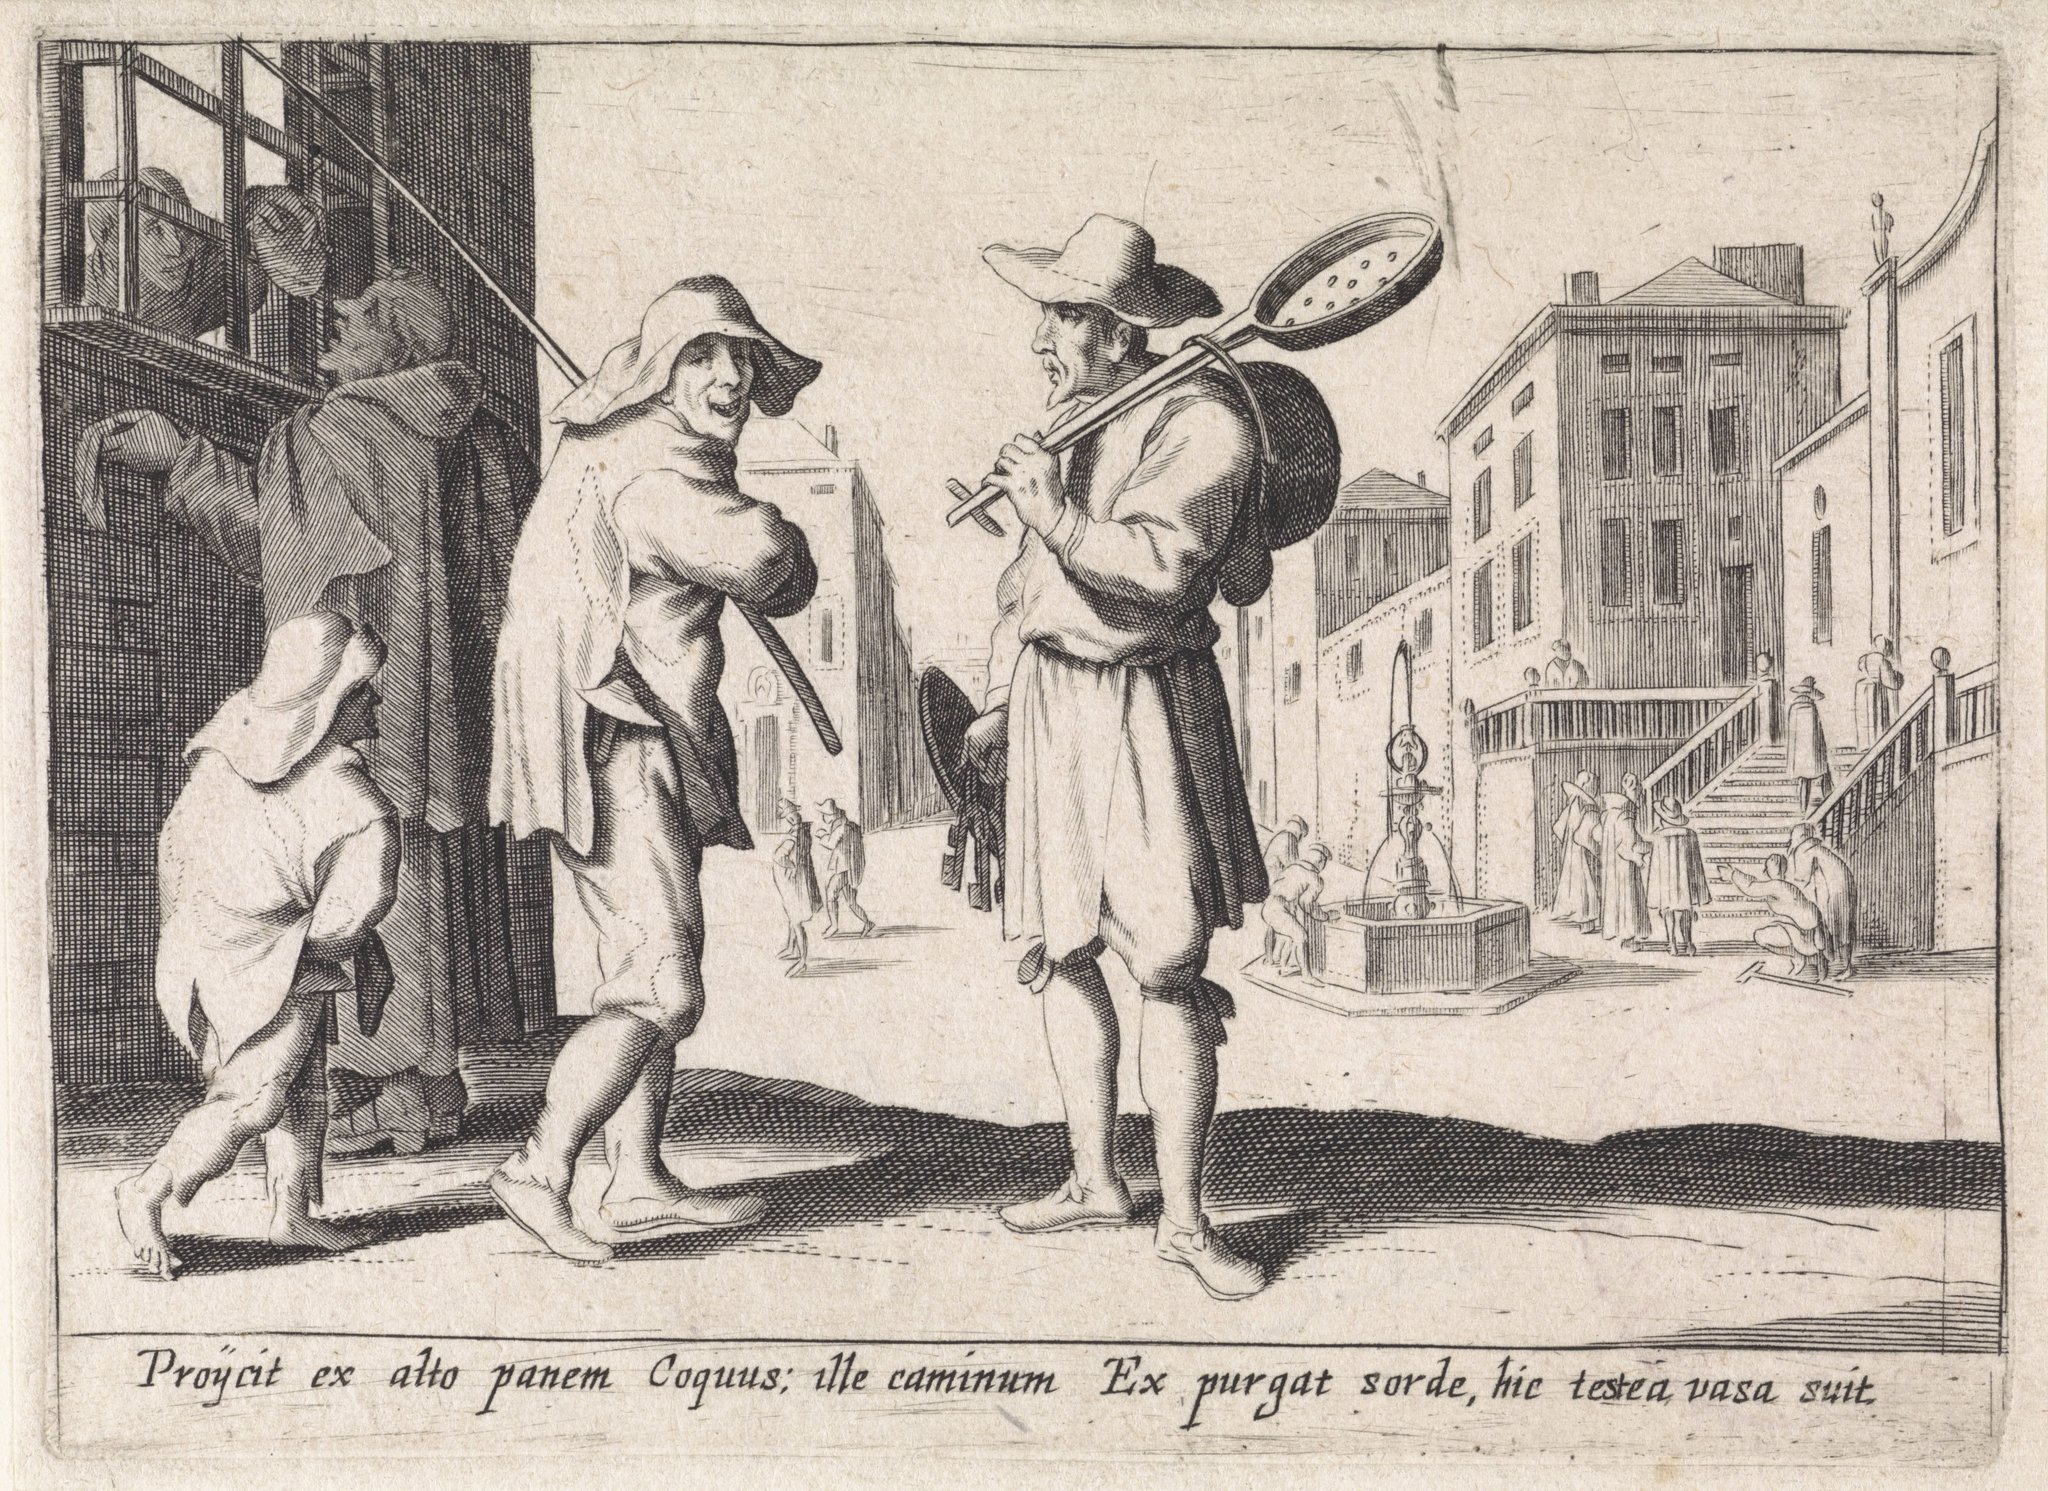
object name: print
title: Verkoper van pannen en sleutels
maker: Anonymous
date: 1613-1667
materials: paper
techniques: engraving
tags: kitchen-utensils: pan, key, monk(s), friar(s), merchant, salesman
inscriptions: collector's mark: Lugt 240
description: Een verkoper van pannen en sleutels op een plein. Links een monnik die door de tralies met een gevangene spreekt. In de marge een onderschrift in het Latijn.